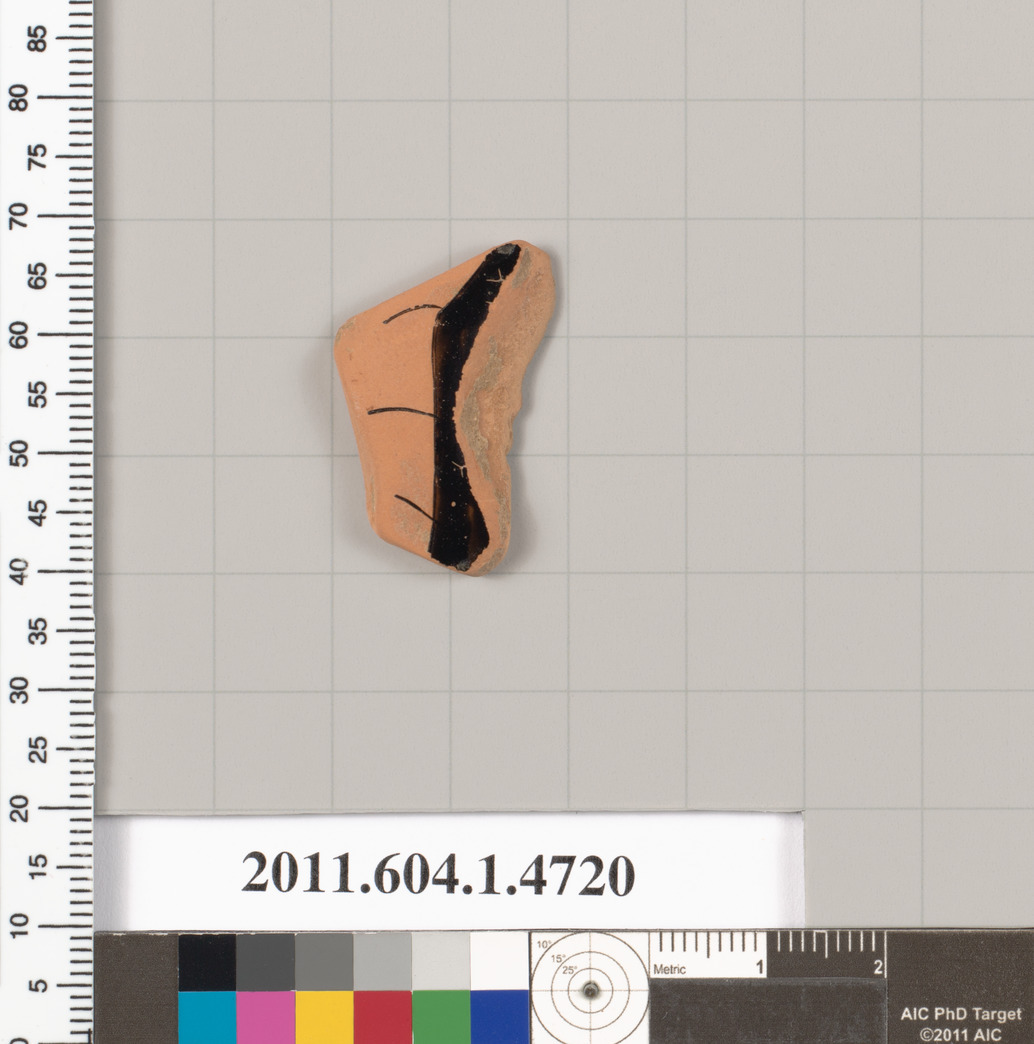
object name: kylix fragment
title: Terracotta fragment of a kylix (drinking cup)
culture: greek, attic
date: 480-470 BCE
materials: terracotta